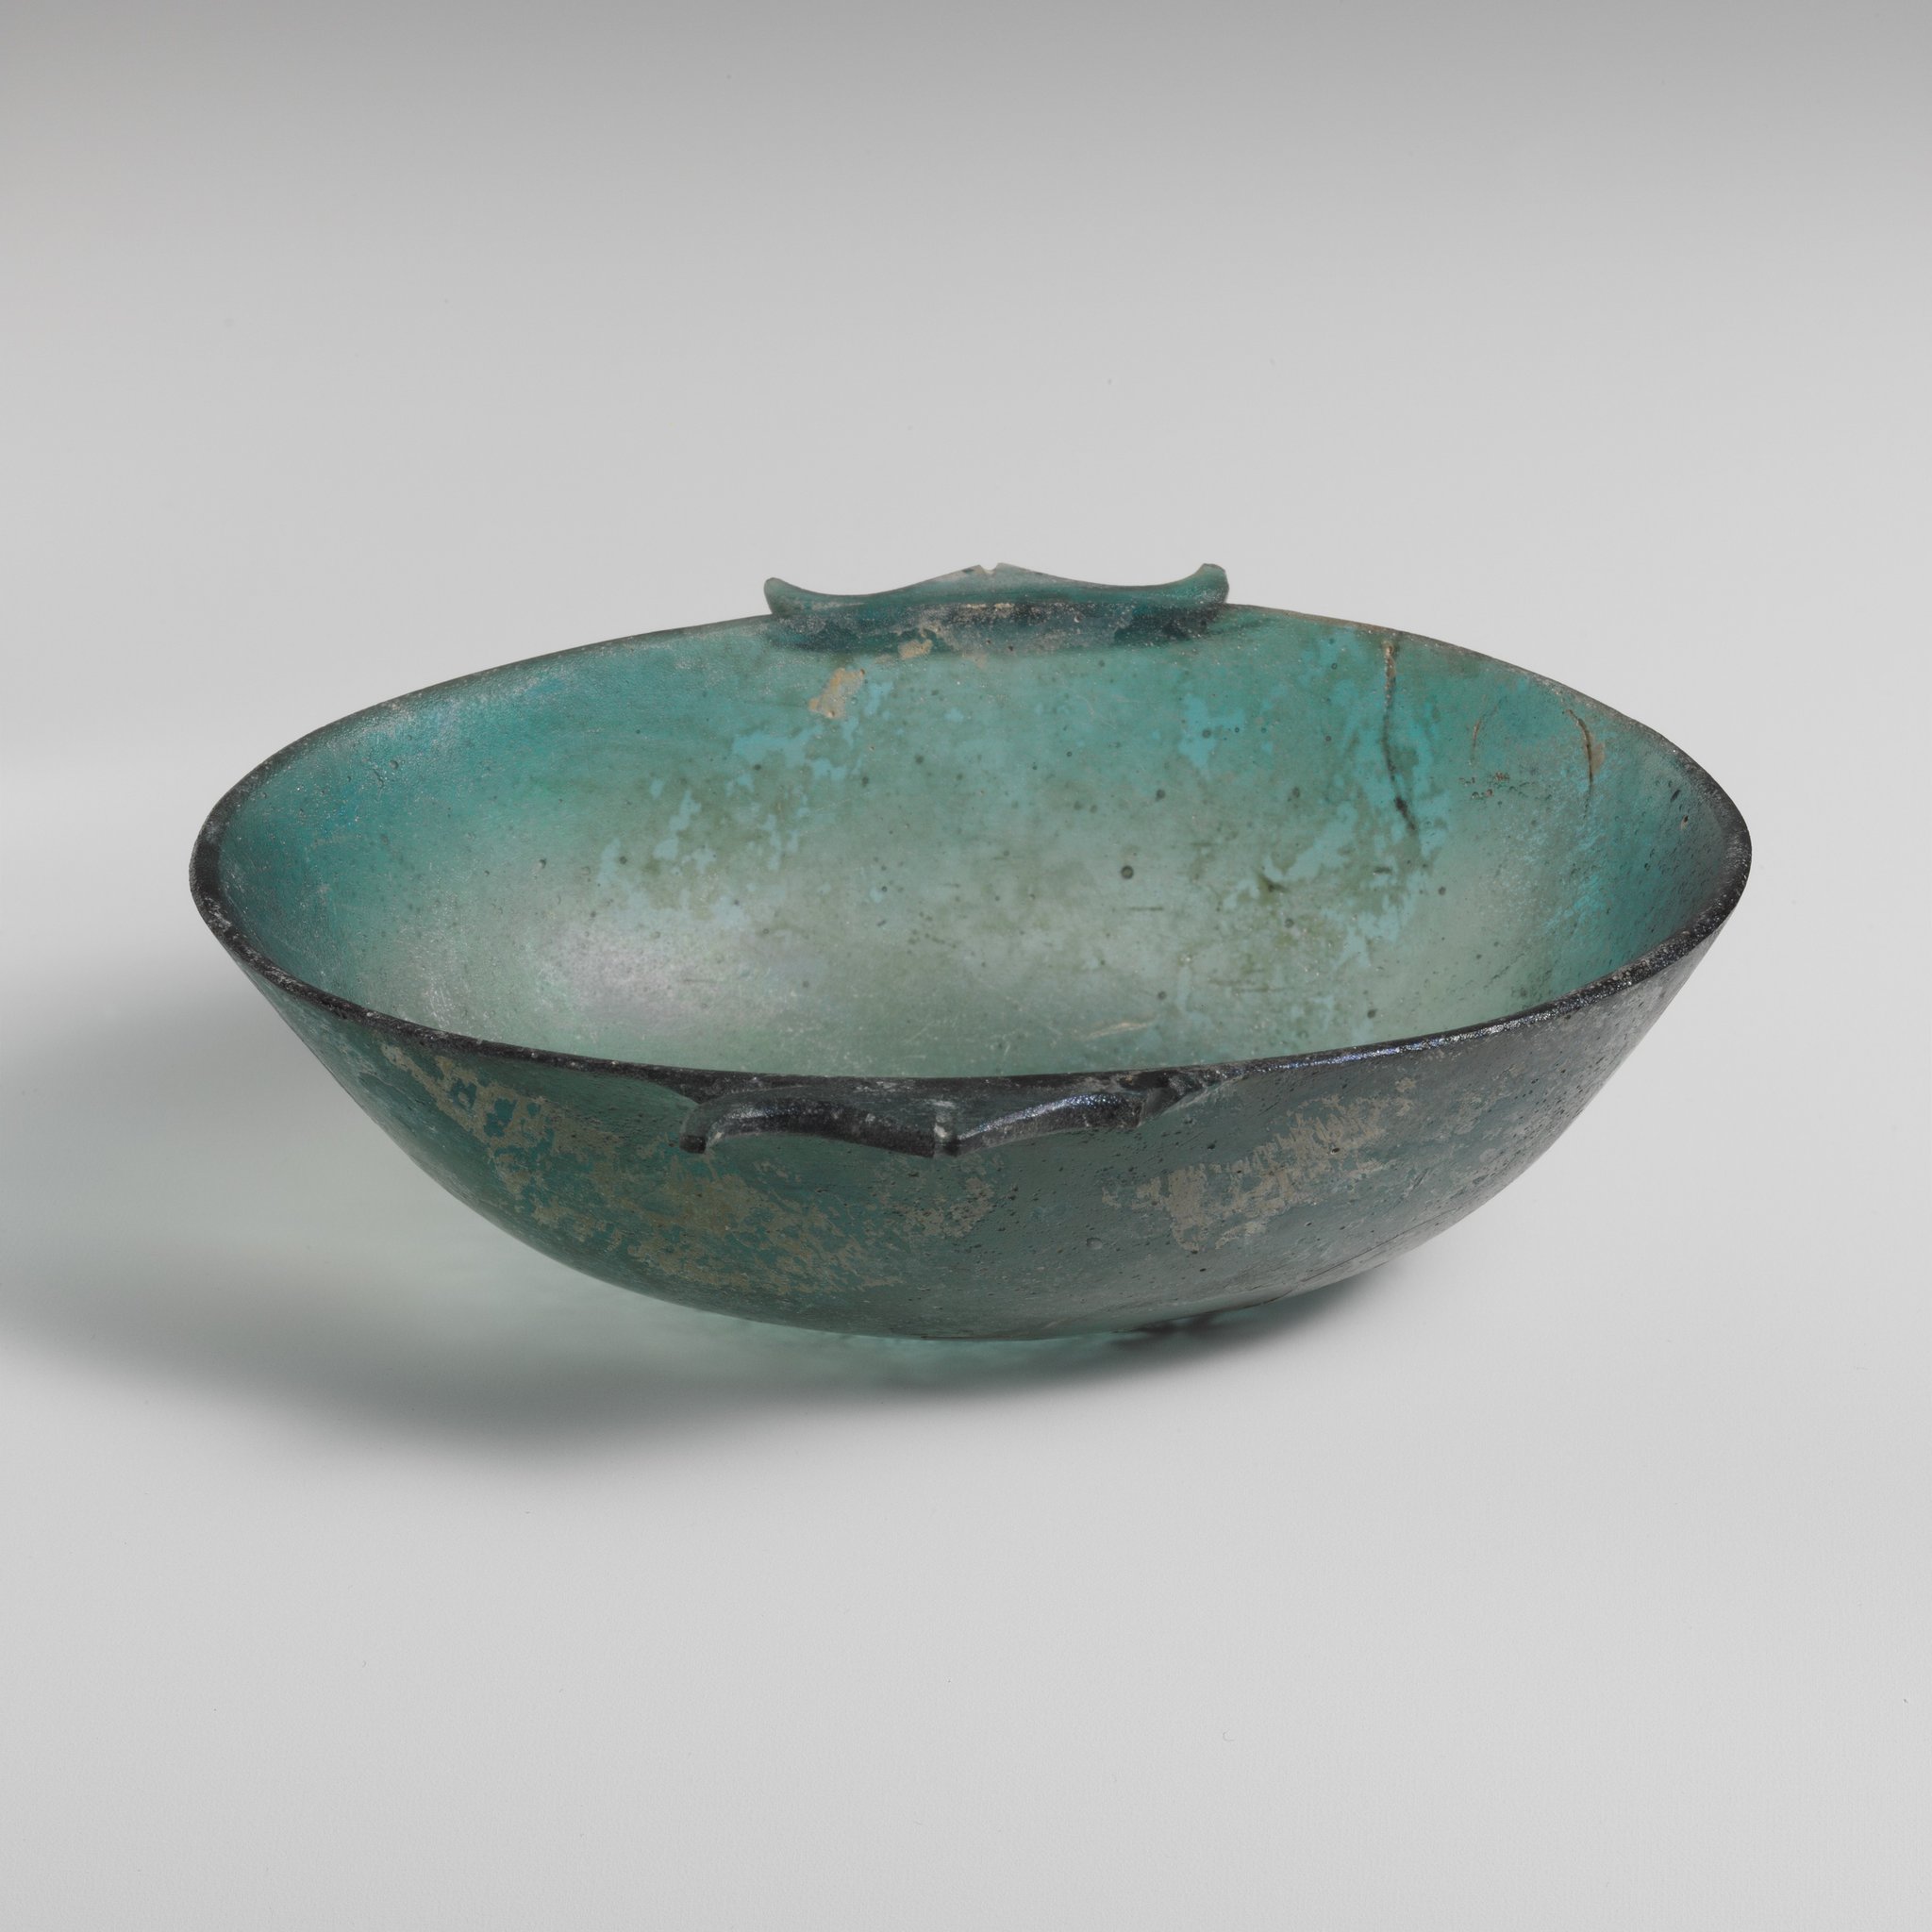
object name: bowl, oval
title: Glass oval bowl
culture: roman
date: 1-50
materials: glass